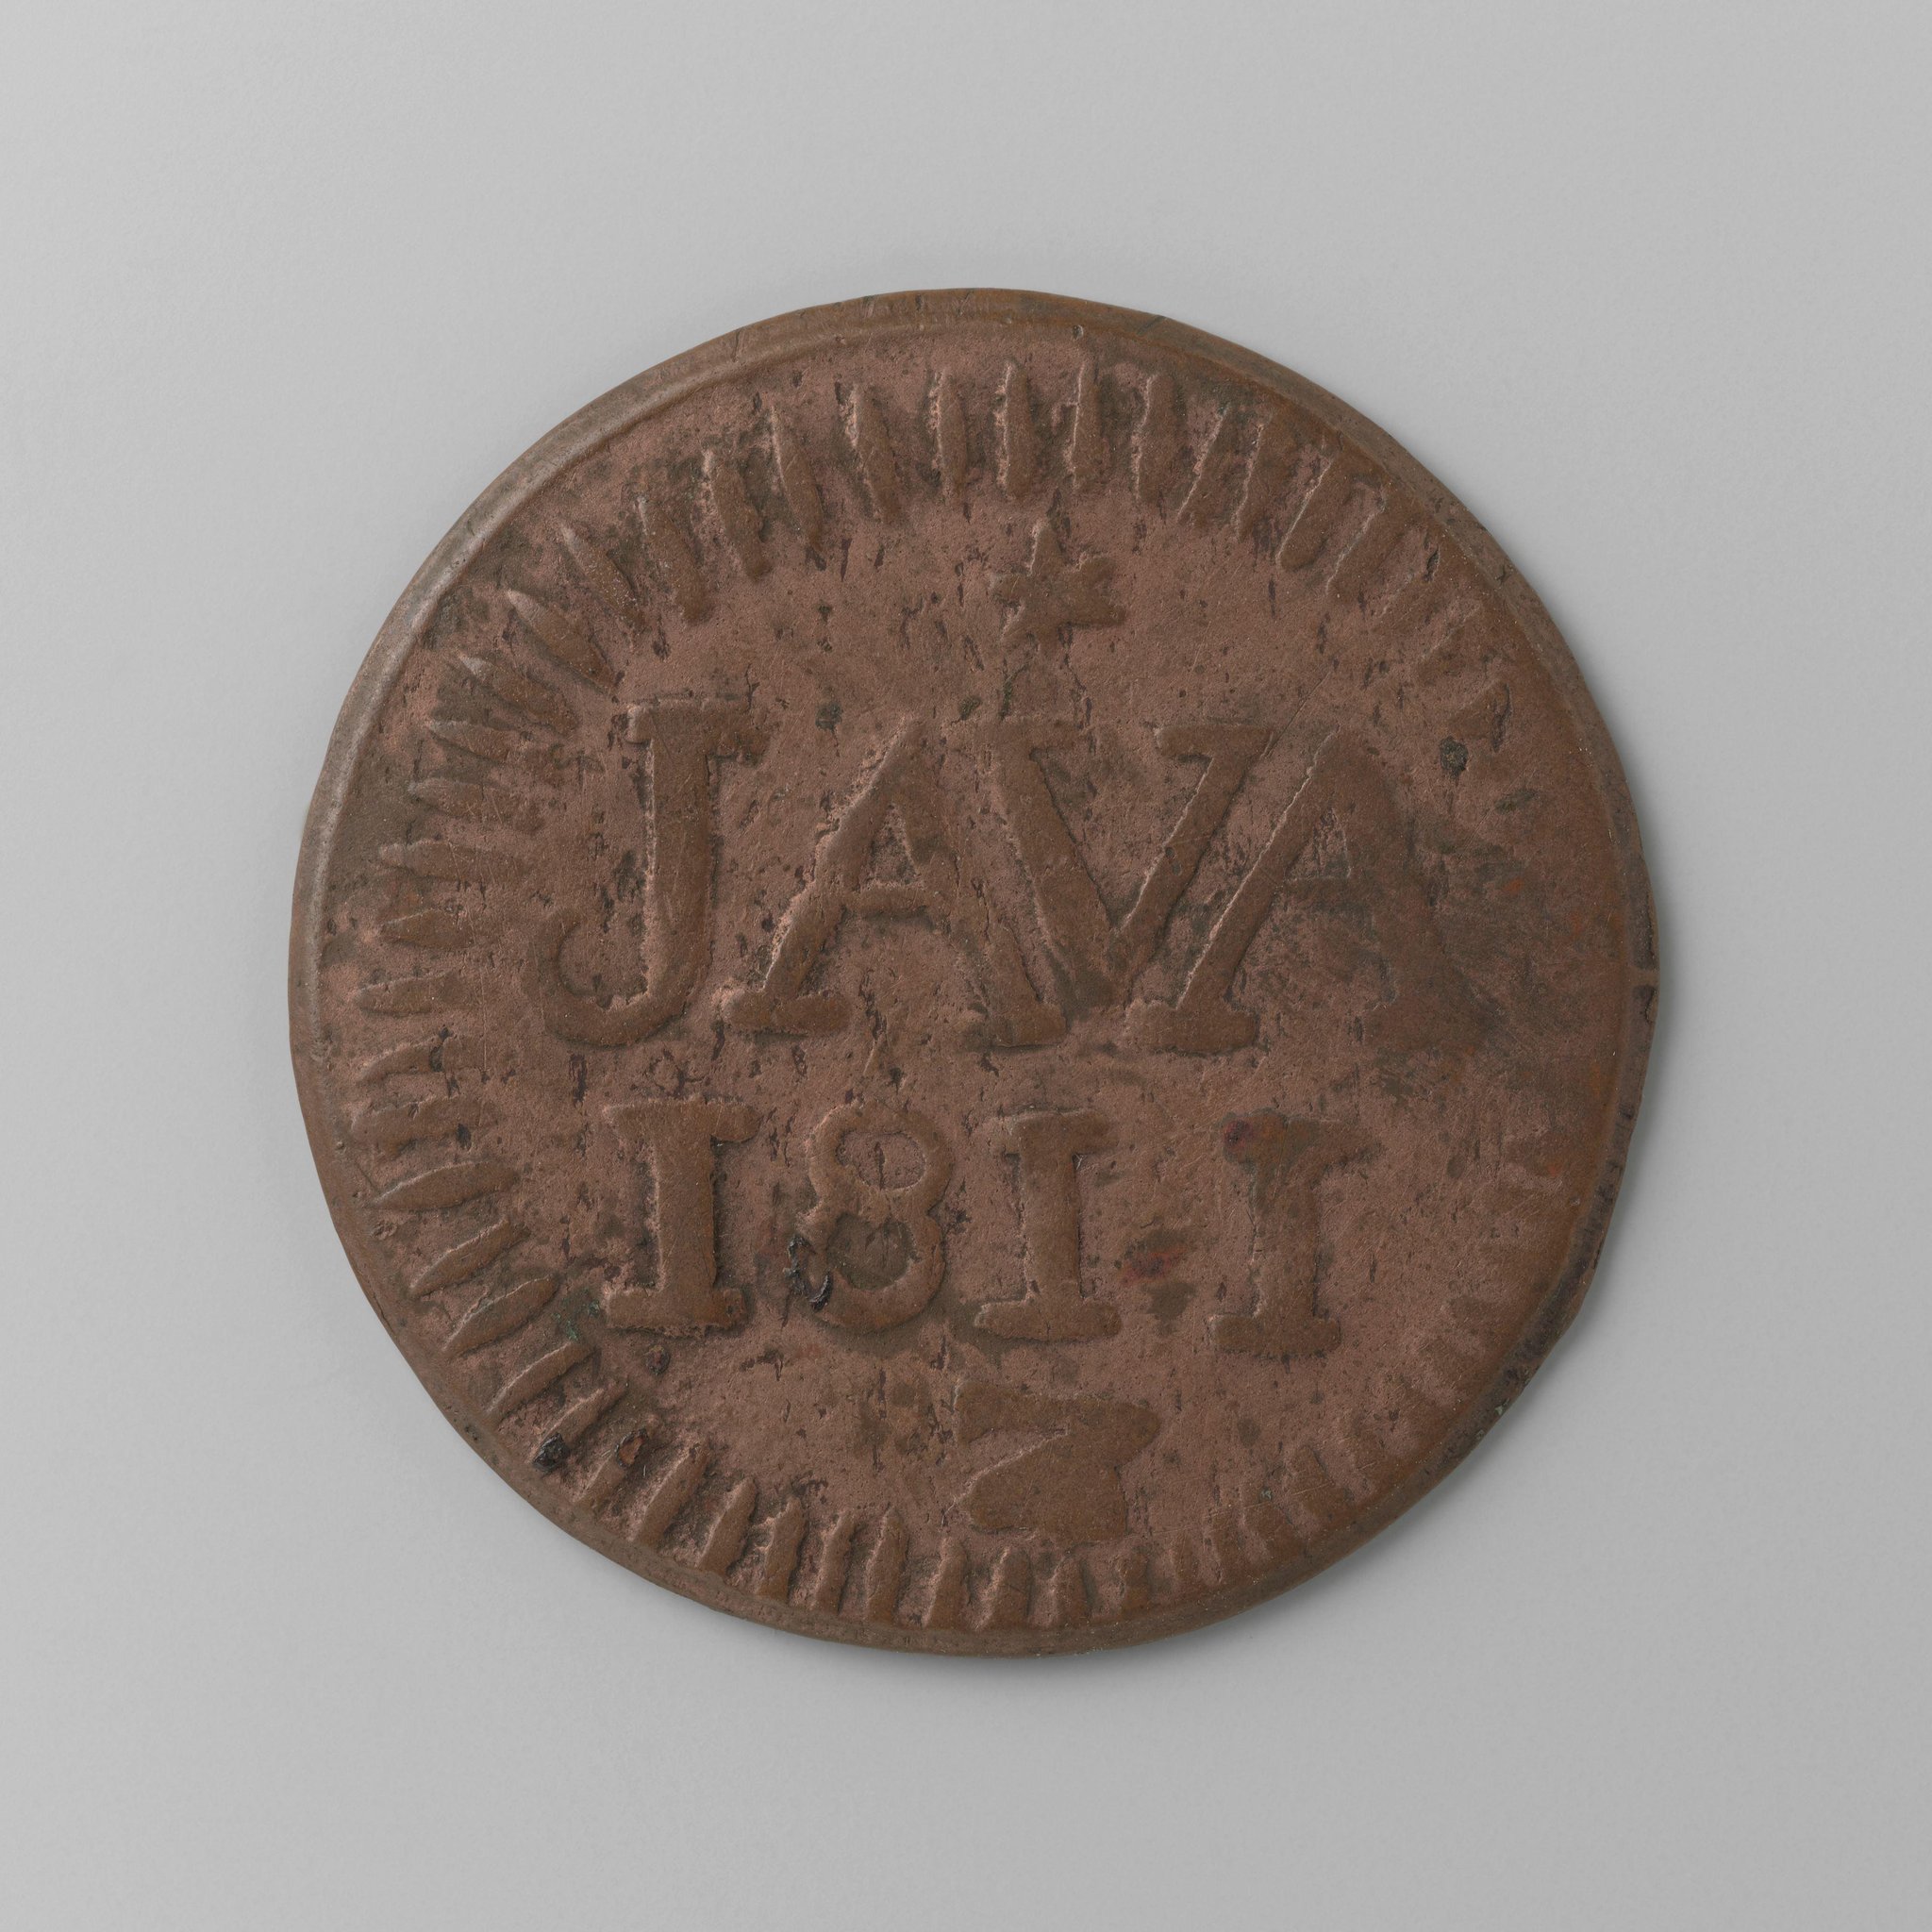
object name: coin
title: ½ stuiver voor Nederlands Indië uit Java, 1811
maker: napoleon i (emperor of the french)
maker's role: generaal, keizer, staatsman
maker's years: 1769-1821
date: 1811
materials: copper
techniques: striking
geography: surabaya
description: Koperen munt. Voorzijde: tussen waarde/aanduiding ½ St ineen gestrengelde initialen L en N van Lodewijk Napoleon. Daarboven muntteken. Keerzijde: eenregelig opschrift, waaronder jaartal. Boven opschrift muntteken en onder jaartal muntmeesterteken Z [=muntmeester Zwekkert].